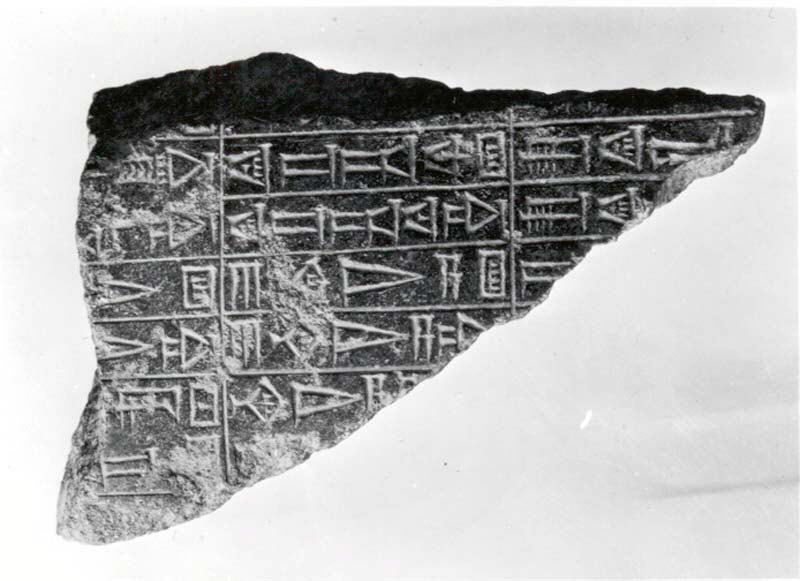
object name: cuneiform inscription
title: Ur-Namma cadastre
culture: neo-sumerian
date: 2112-2095 BCE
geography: mesopotamia